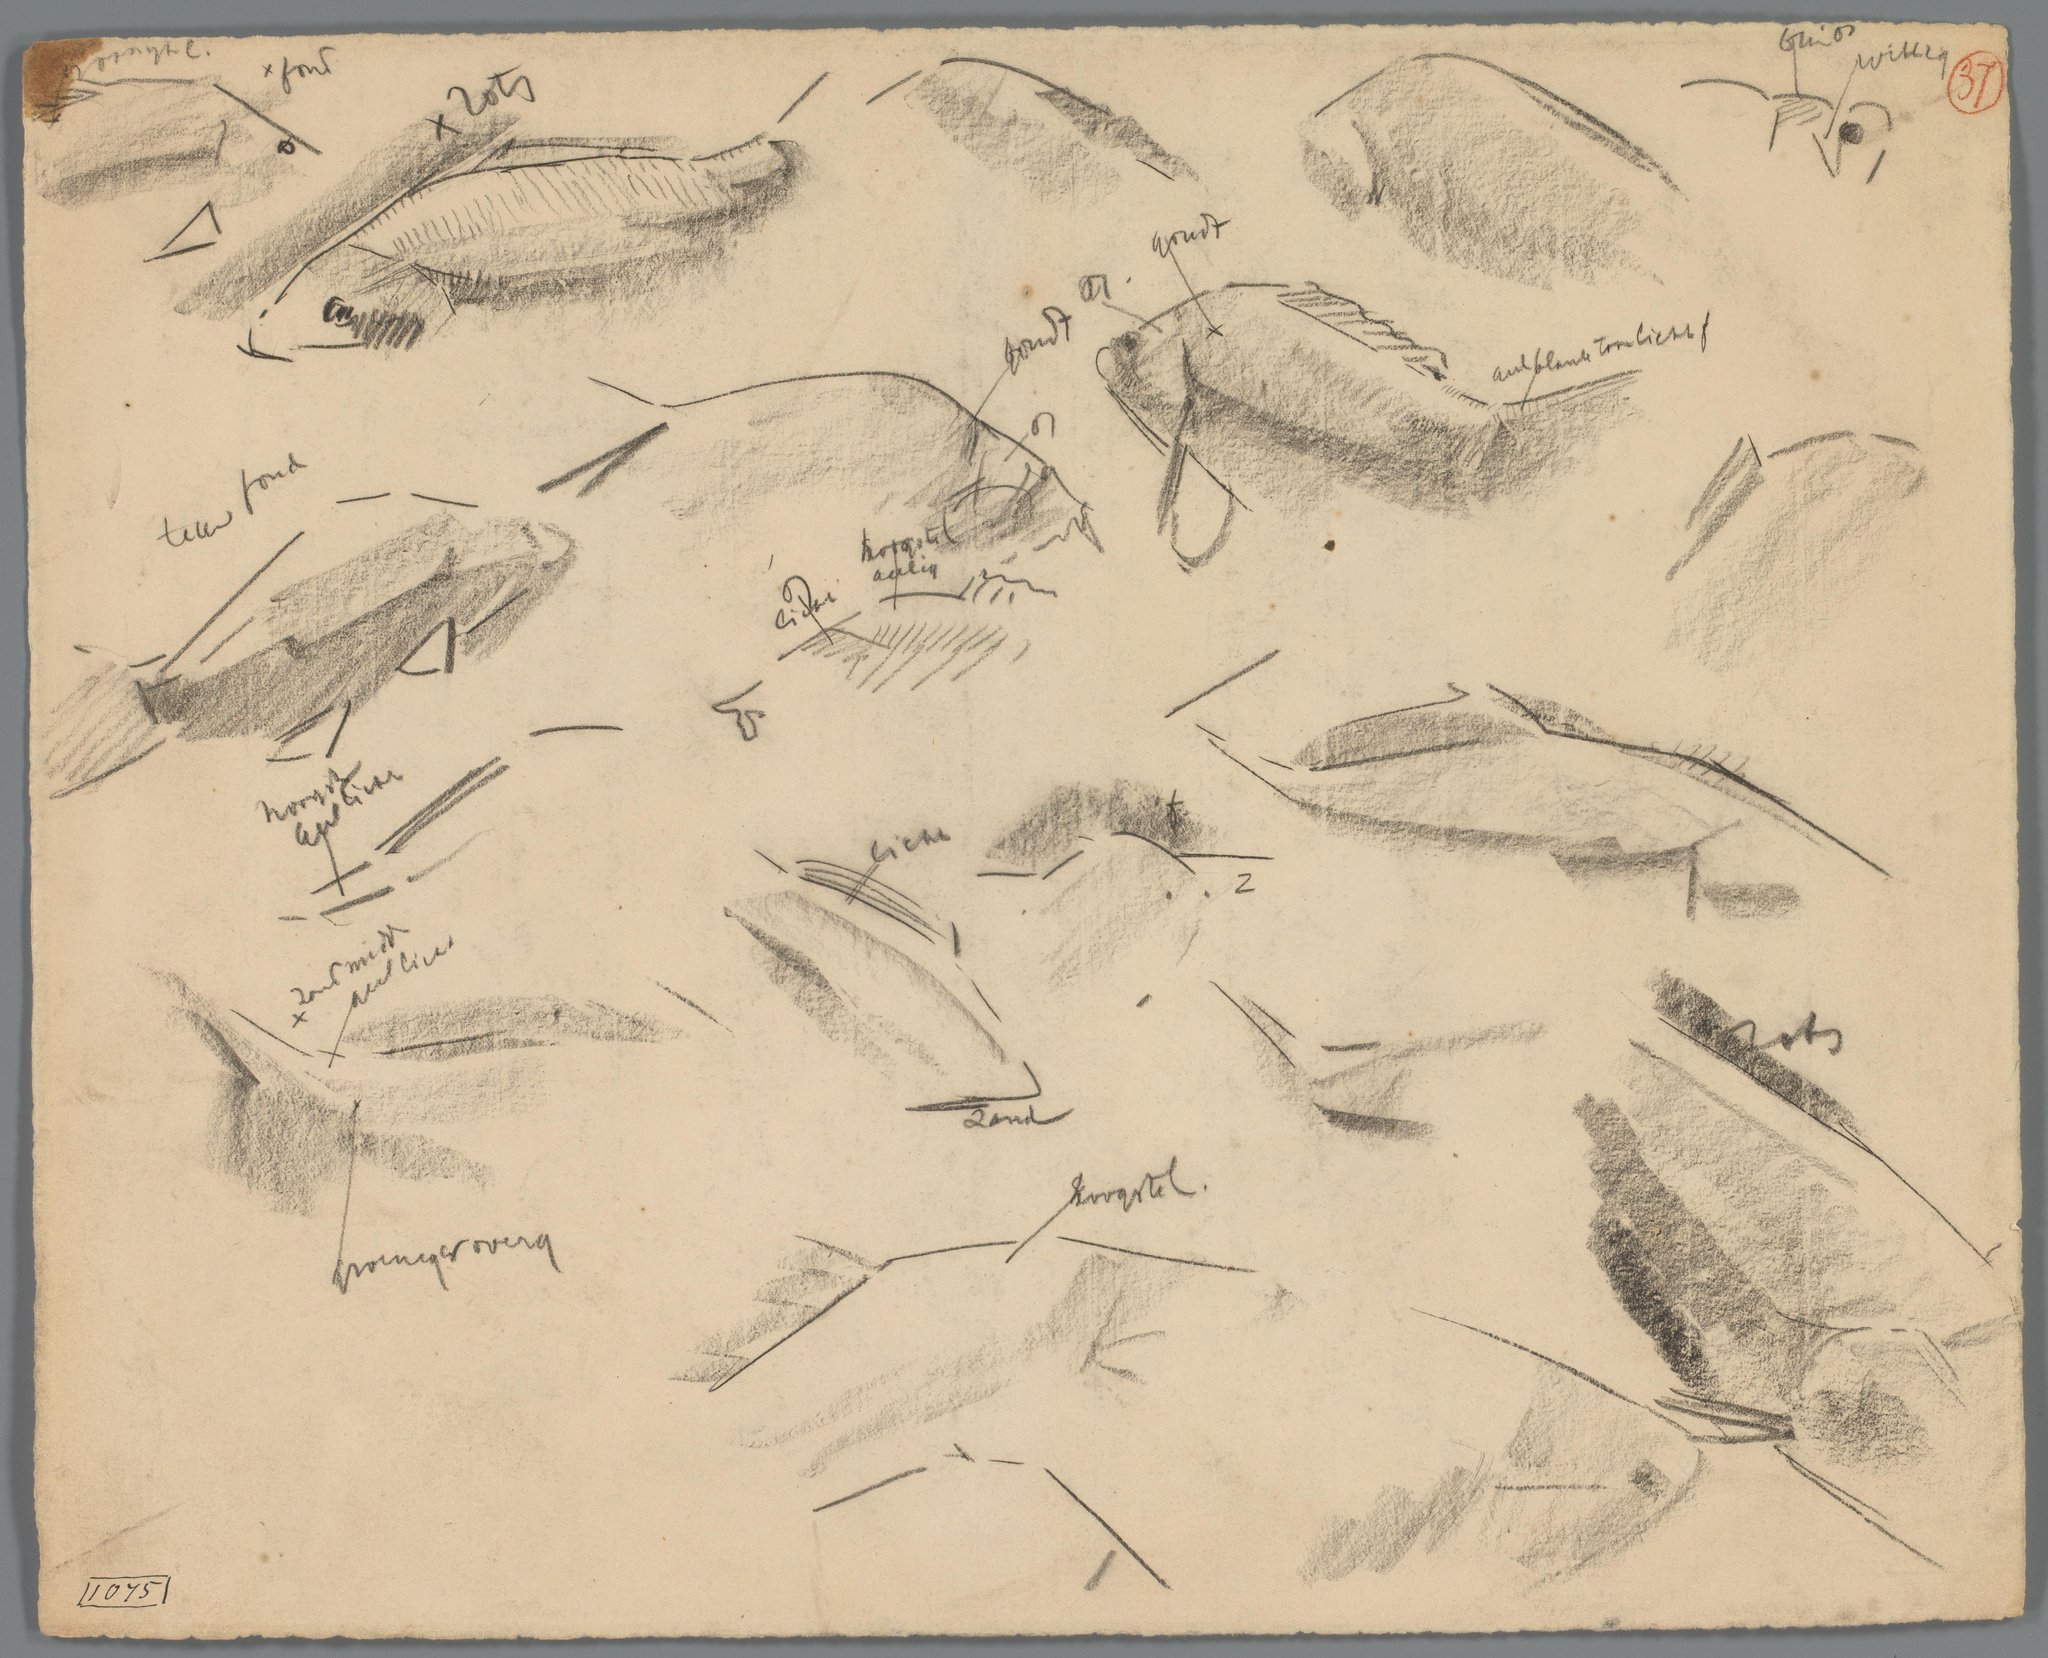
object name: drawing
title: Studies van karpers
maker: gerrit willem dijsselhof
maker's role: designer, draughtsman, print maker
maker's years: 1866-1924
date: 1876-1924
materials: chalk, paper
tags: bony fishes: carp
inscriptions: number: ‘1075’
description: Met aantekeningen. Rechtsboven genummerd: 37.